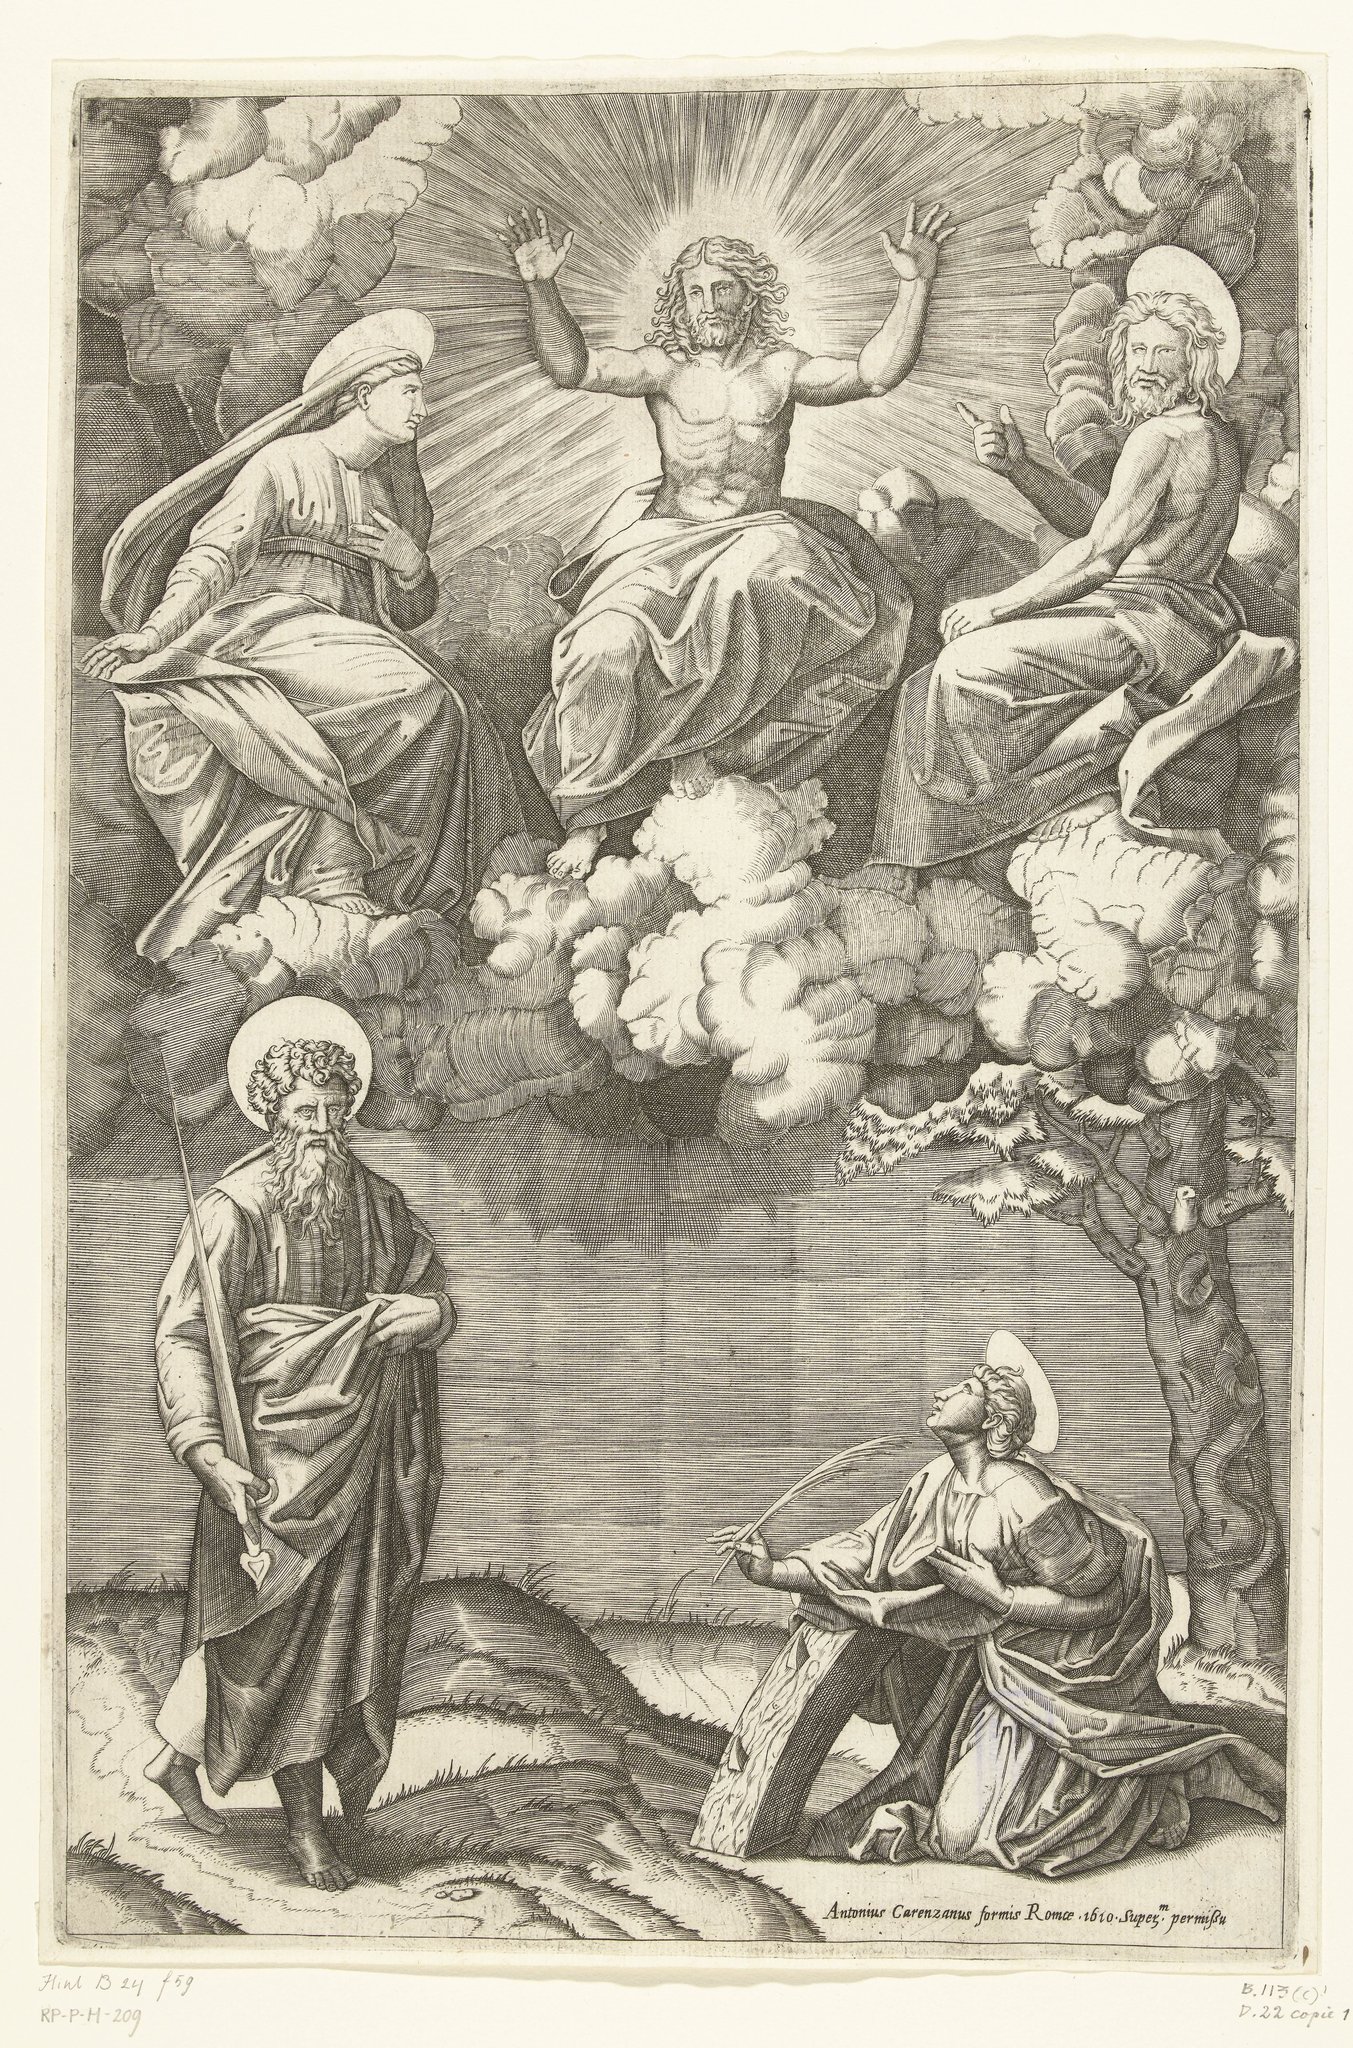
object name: print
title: Christus en Maria en Johannes de Doper met heiligen Paulus en Catharina van Alexandrië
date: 1520-1610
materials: paper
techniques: engraving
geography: rome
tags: adult christ with mary, adult christ together with apostles, evangelists, saints, etc.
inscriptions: collector's mark: Lugt 11, collector's mark: Lugt 10, inscription: ‘B 24 f 59’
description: Kopie naar prent van Marcantonio Raimondi. Raimondi baseerde zijn prent mogelijk op een ontwerp van Giulio Romano. Het modello waarop deze prent werd gebaseerd lijkt kwalitatief niet goed genoeg om aan Rafael toe te schrijven maar is wel vervaardigd door iemand uit zijn directe omgeving (Louvre, Parijs). Stilistisch tonen de figuren meer verwantschap met werk van Giulio Romano (Shoemaker 1981, p. 180-182).